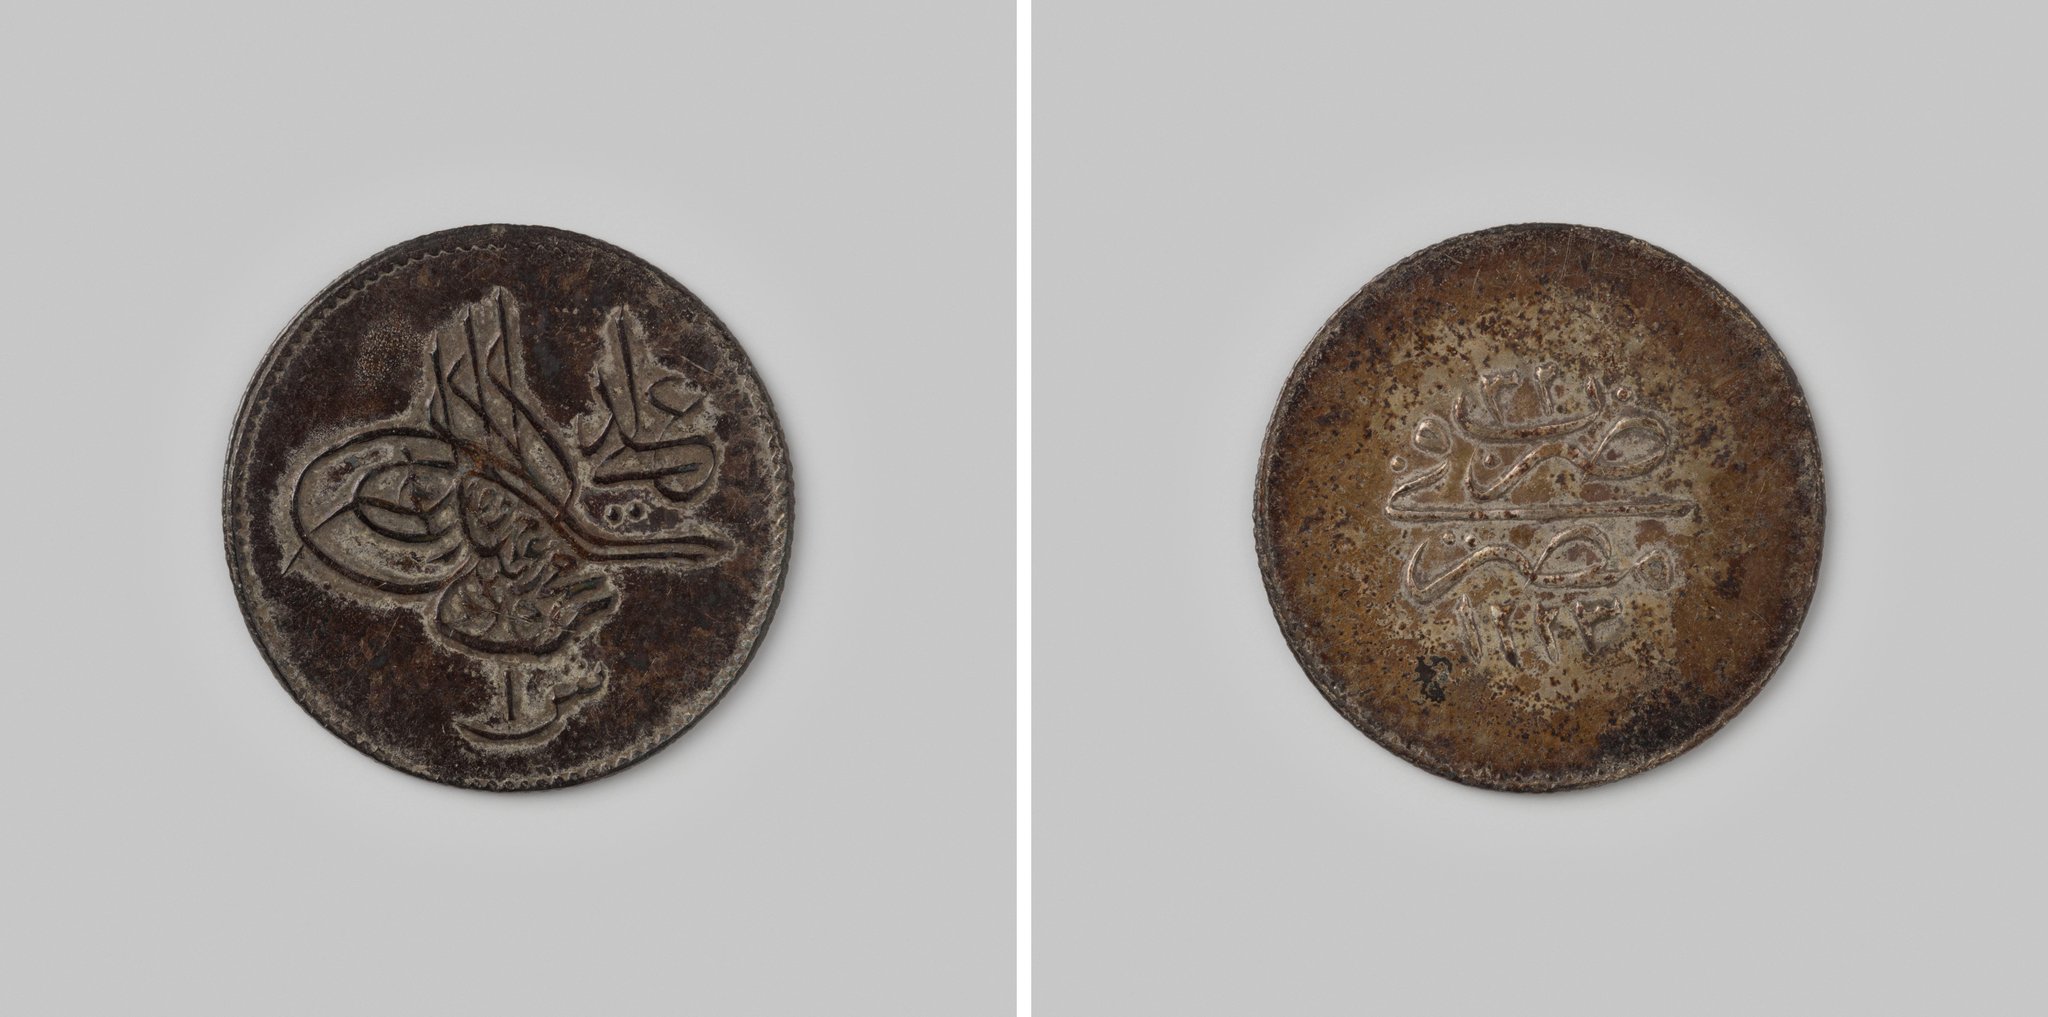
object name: coin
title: Qirsh uit Egypte van de Ottomaanse sultan Abdul Hamid II,1297 [=1881]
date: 1851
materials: silver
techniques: striking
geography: cairo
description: Zilveren munt. Voorzijde: tughra met rechts daarvan een tak met bladeren. Onder de tughra waarde-aanduiding: 1 qirsh. Keerzijde: drieregelig opschrift in Arabische letters: zuriba fi Misr [=Egypte, Caïro]. Daarboven cijfer: 5 [=regeringsjaar] en daaronder jaar van aantreden:1293.